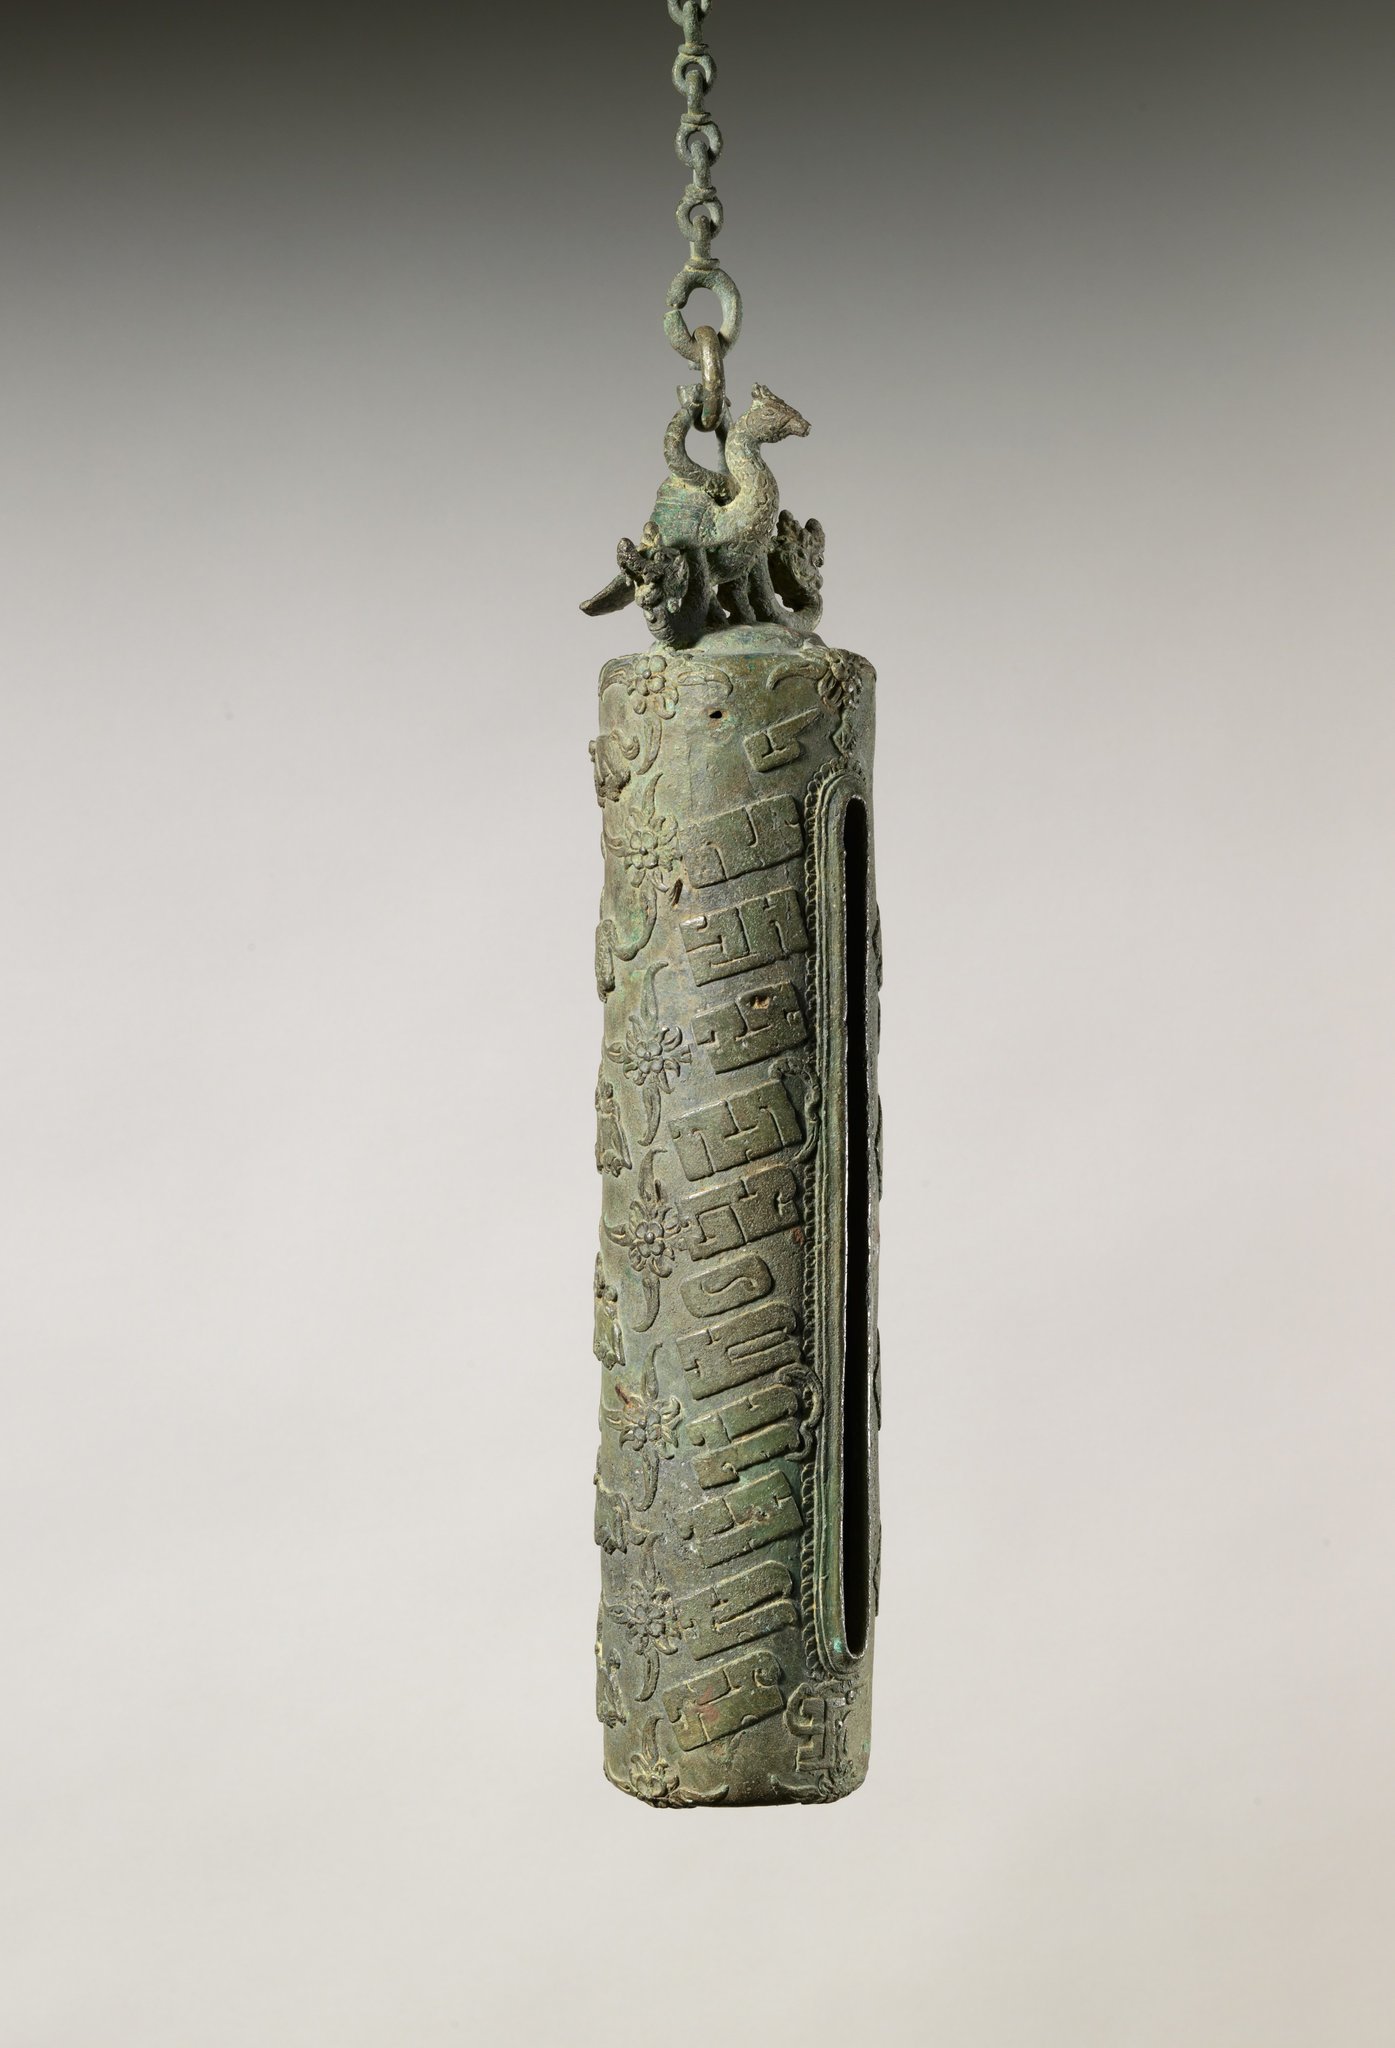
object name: slit gong kentongan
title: Slit Gong (Kentongan)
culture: indonesian, javanese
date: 1201-1300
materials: bronze